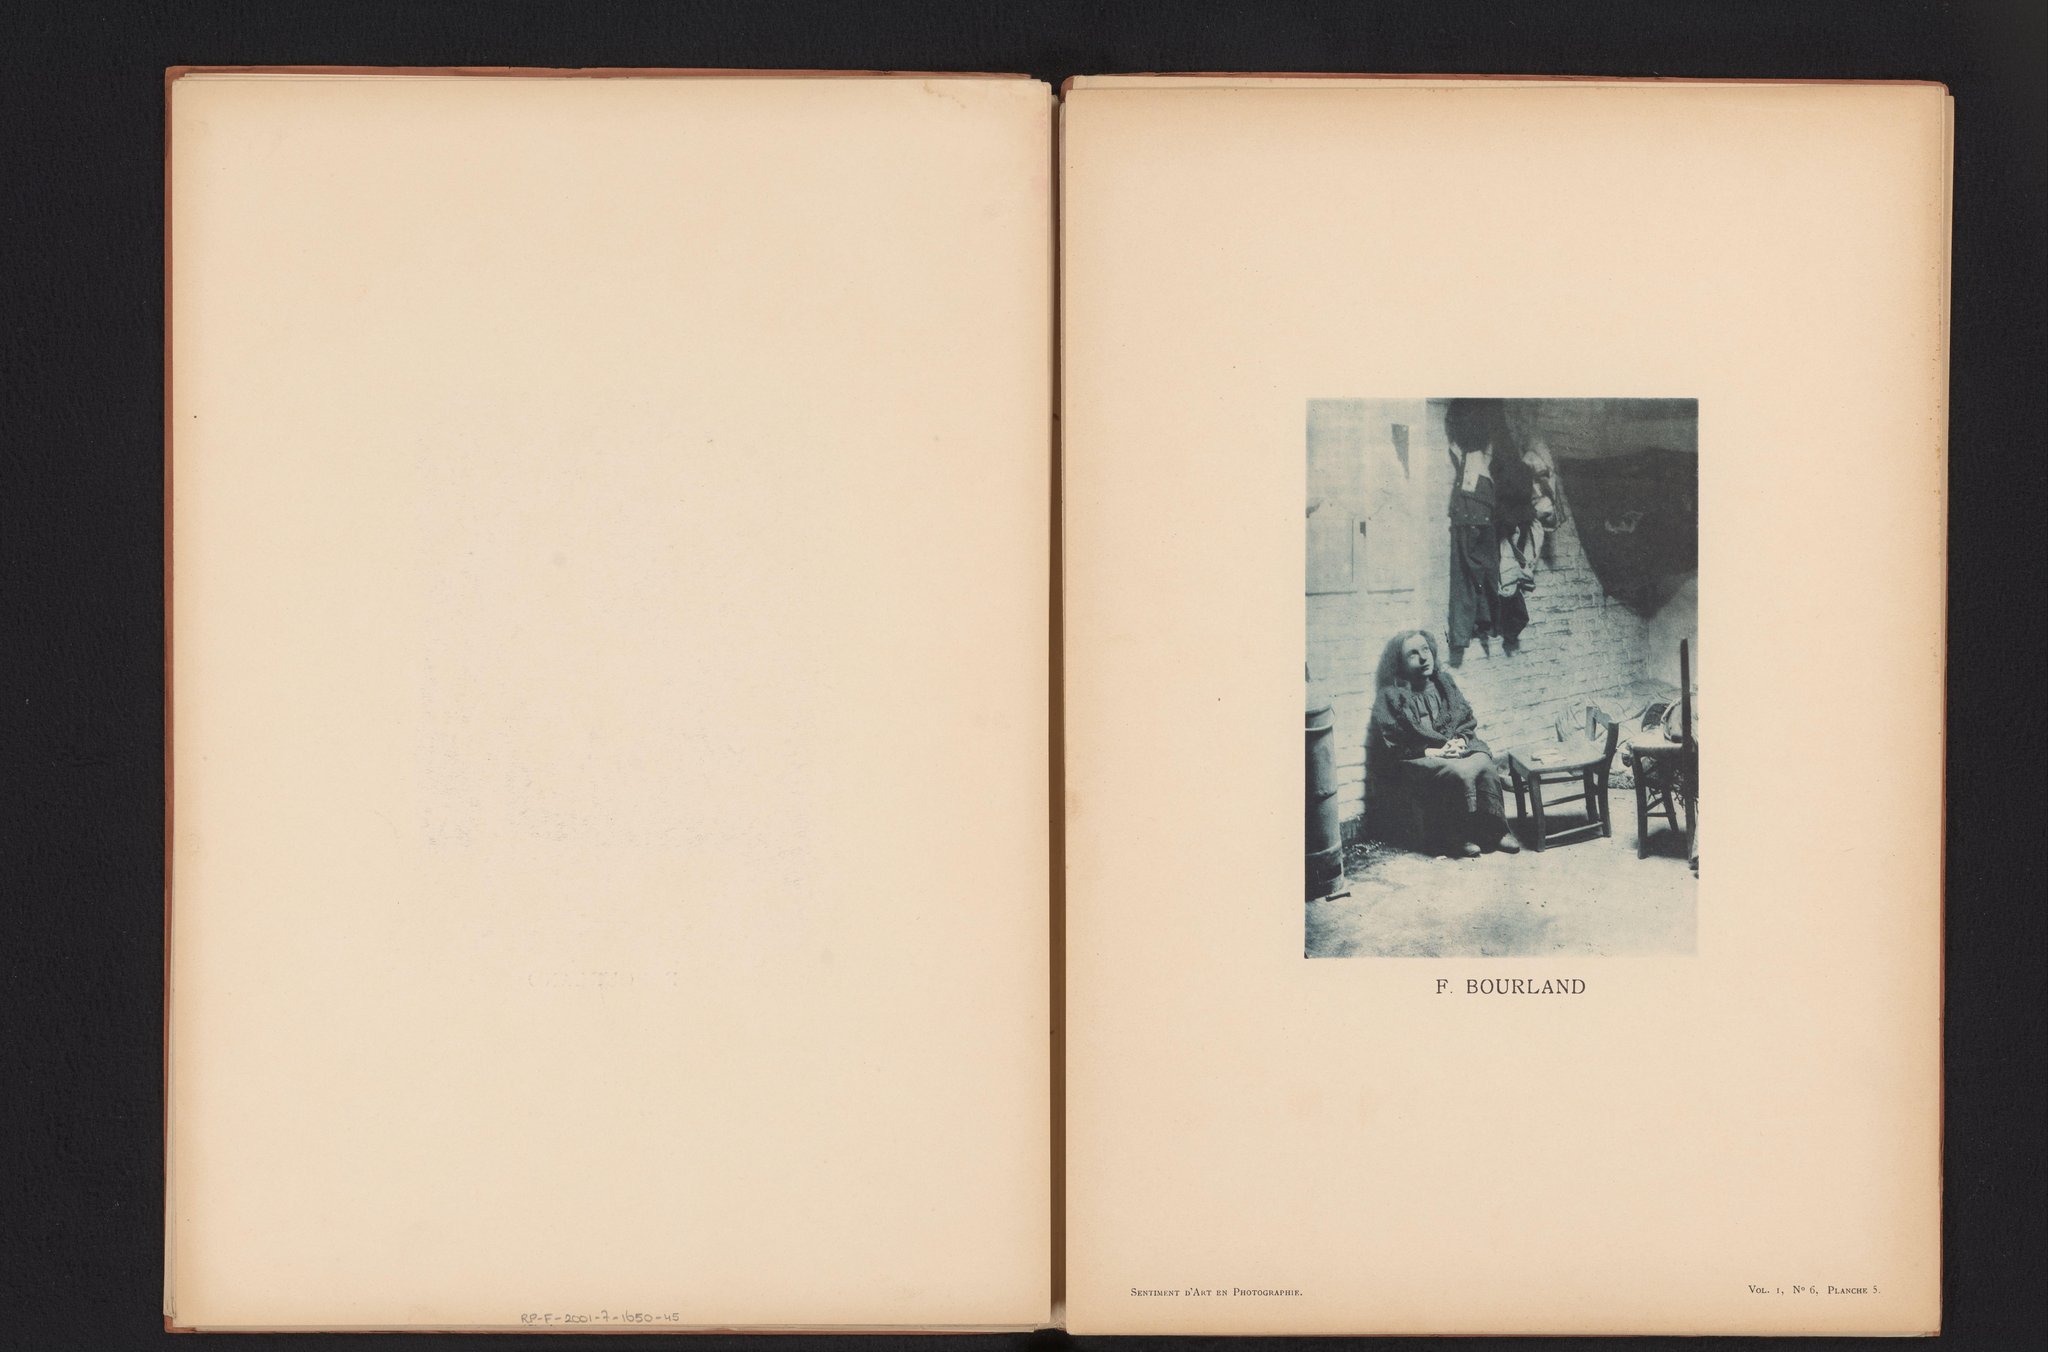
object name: photomechanical print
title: Kind op een kruk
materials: paper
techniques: photograph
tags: stool, child between toddler and youth (of undetermined sex)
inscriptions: number: ‘Vol. 1, No 6, Planche 5.’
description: Deze prent maakt deel uit van 8 omslagen met 22 tekstbladen en 89 prenten op losse bladen in en tussen de omslagen.